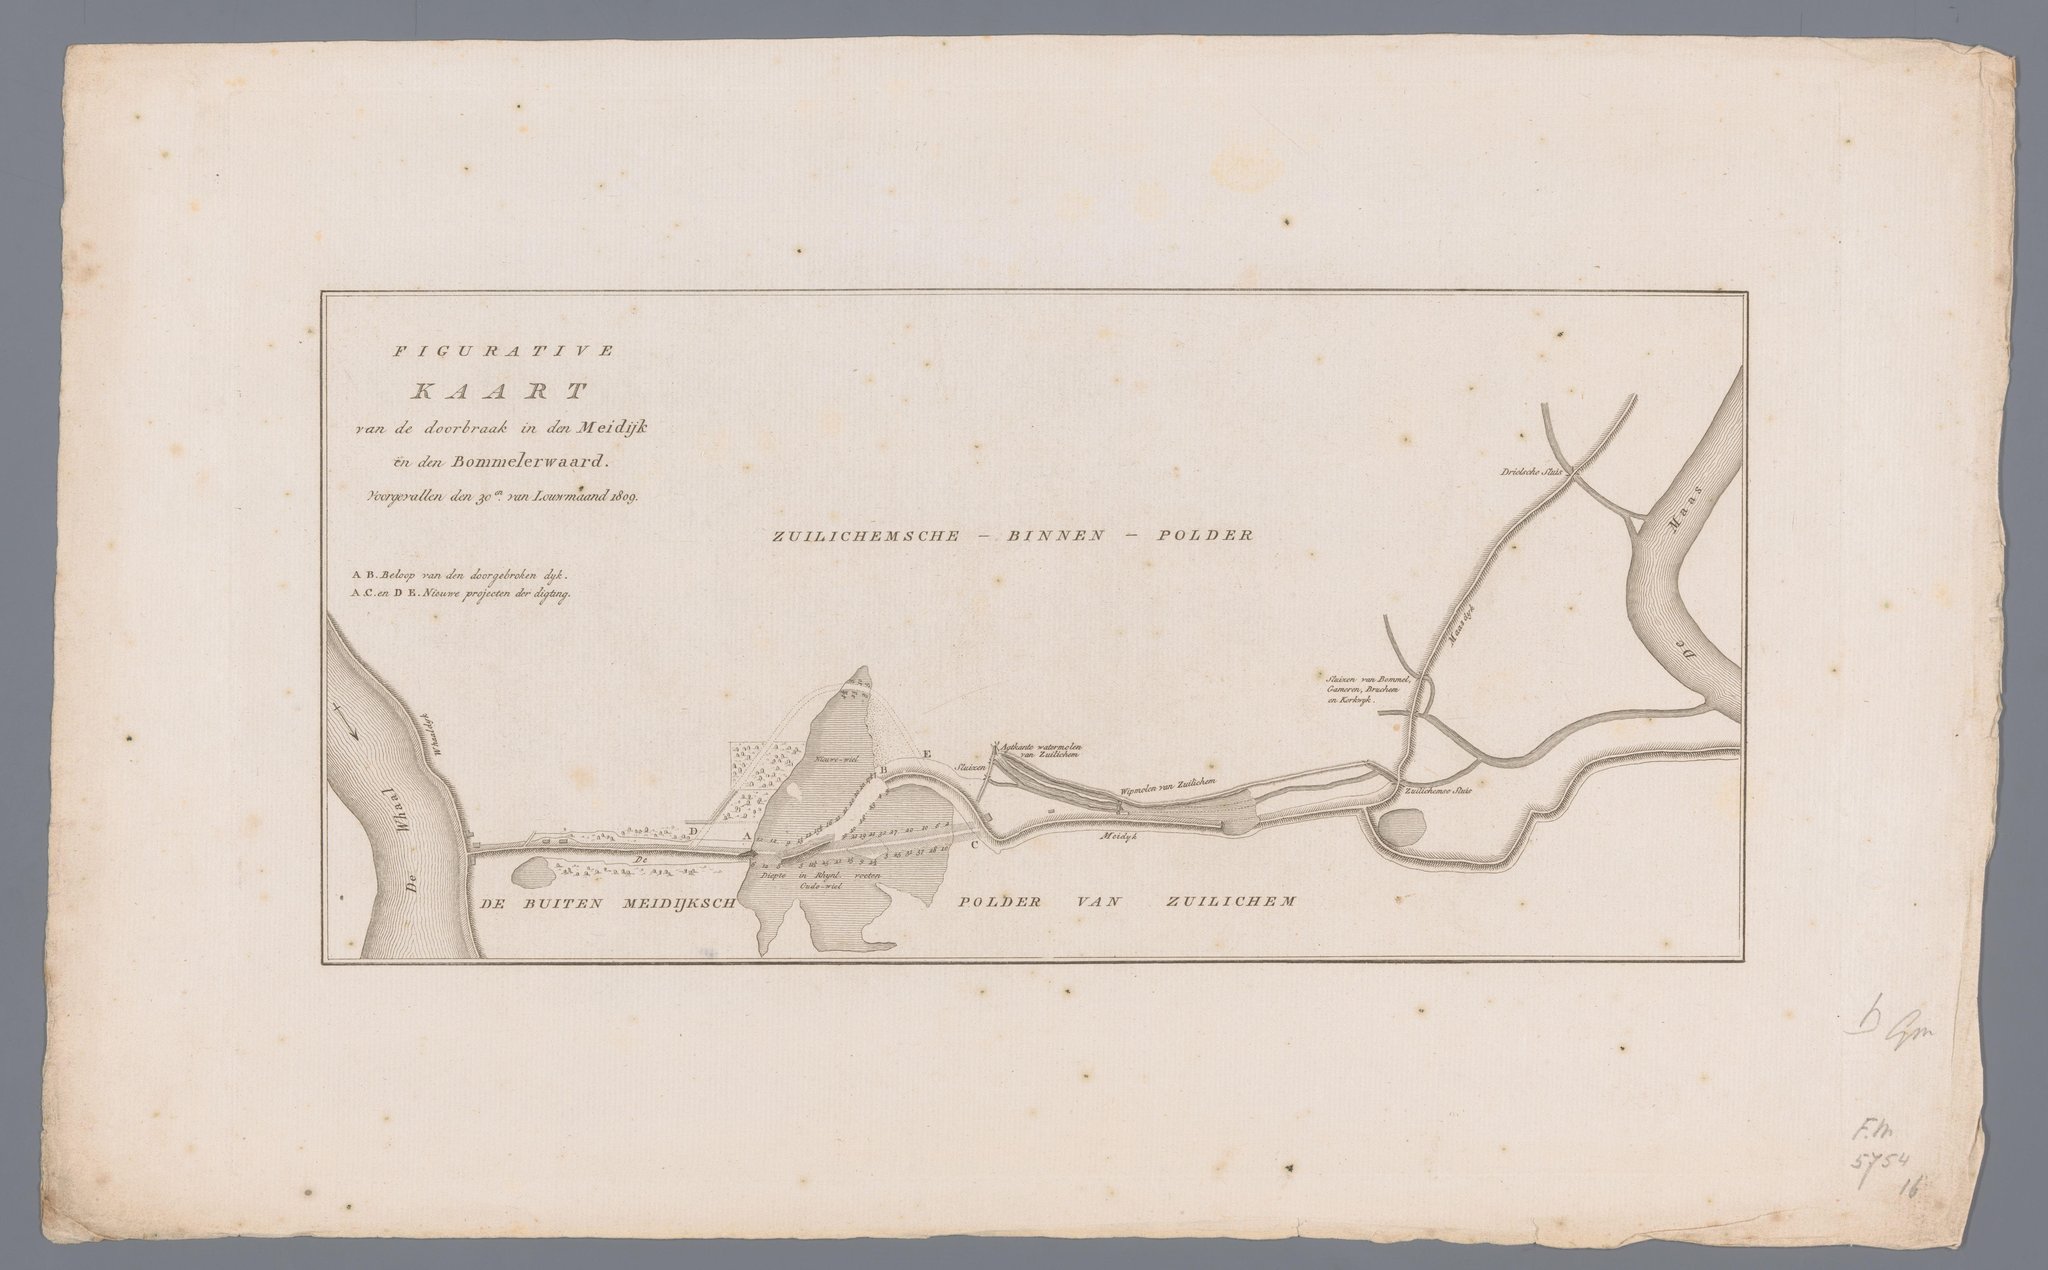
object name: map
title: Figurative Kaart van de doorbraak in den Meidijk in den Bommelerwaard, voorgevallen den 30en van Louwmaand 1809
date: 1809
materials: paper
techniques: etching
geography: amsterdam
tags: dike-break, maps of separate countries or regions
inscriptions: collector's mark: Lugt 2228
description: Prent uit: Ewijk, Hendrik. Geschiedkundig verslag der dijkbreuken en overstroomingen, langs de rivieren in het Koningrijk Holland, voorgevallen in louwmaand MDCCCIX. Amsterdam: Johannes Allart en Jacobus Ruys, 1809.